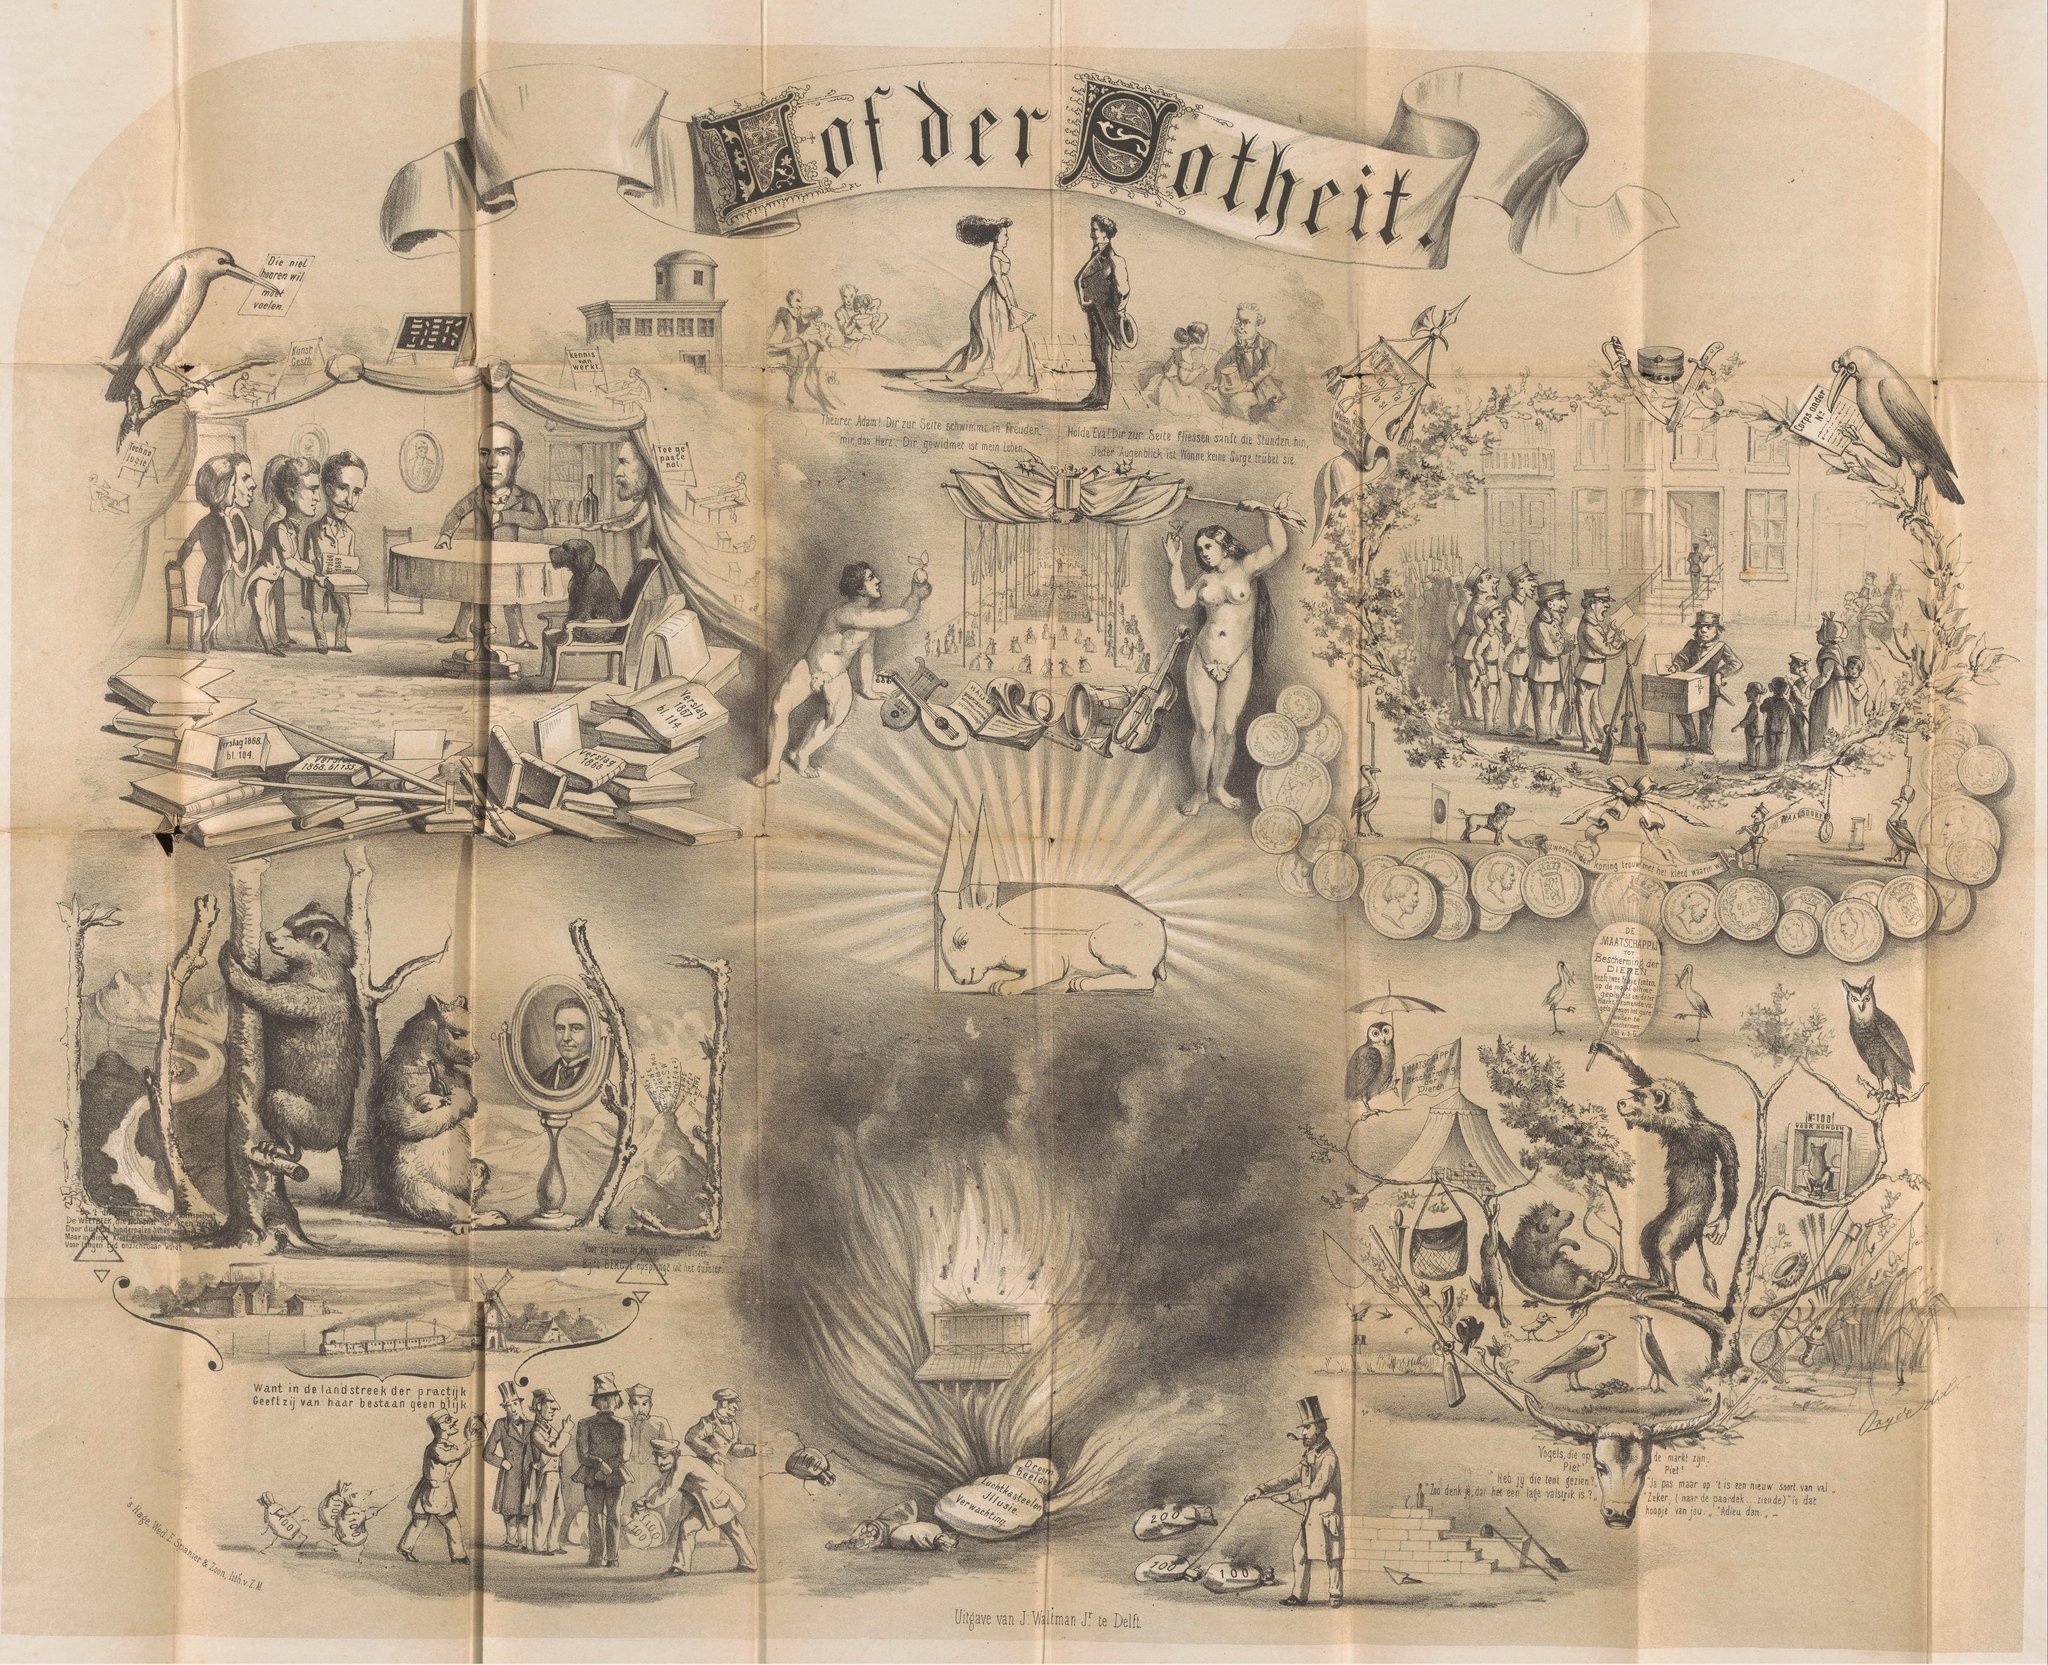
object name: print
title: Spotprent in Delftse studentenalmanak, 1869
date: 1869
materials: paper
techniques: tone lithography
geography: the hague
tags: university, student life, delft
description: Blad met verschillende voorstellingen van het studentenleven. Spotprent in de studentenalmanak van de Delftsche Academie van het jaar 1869